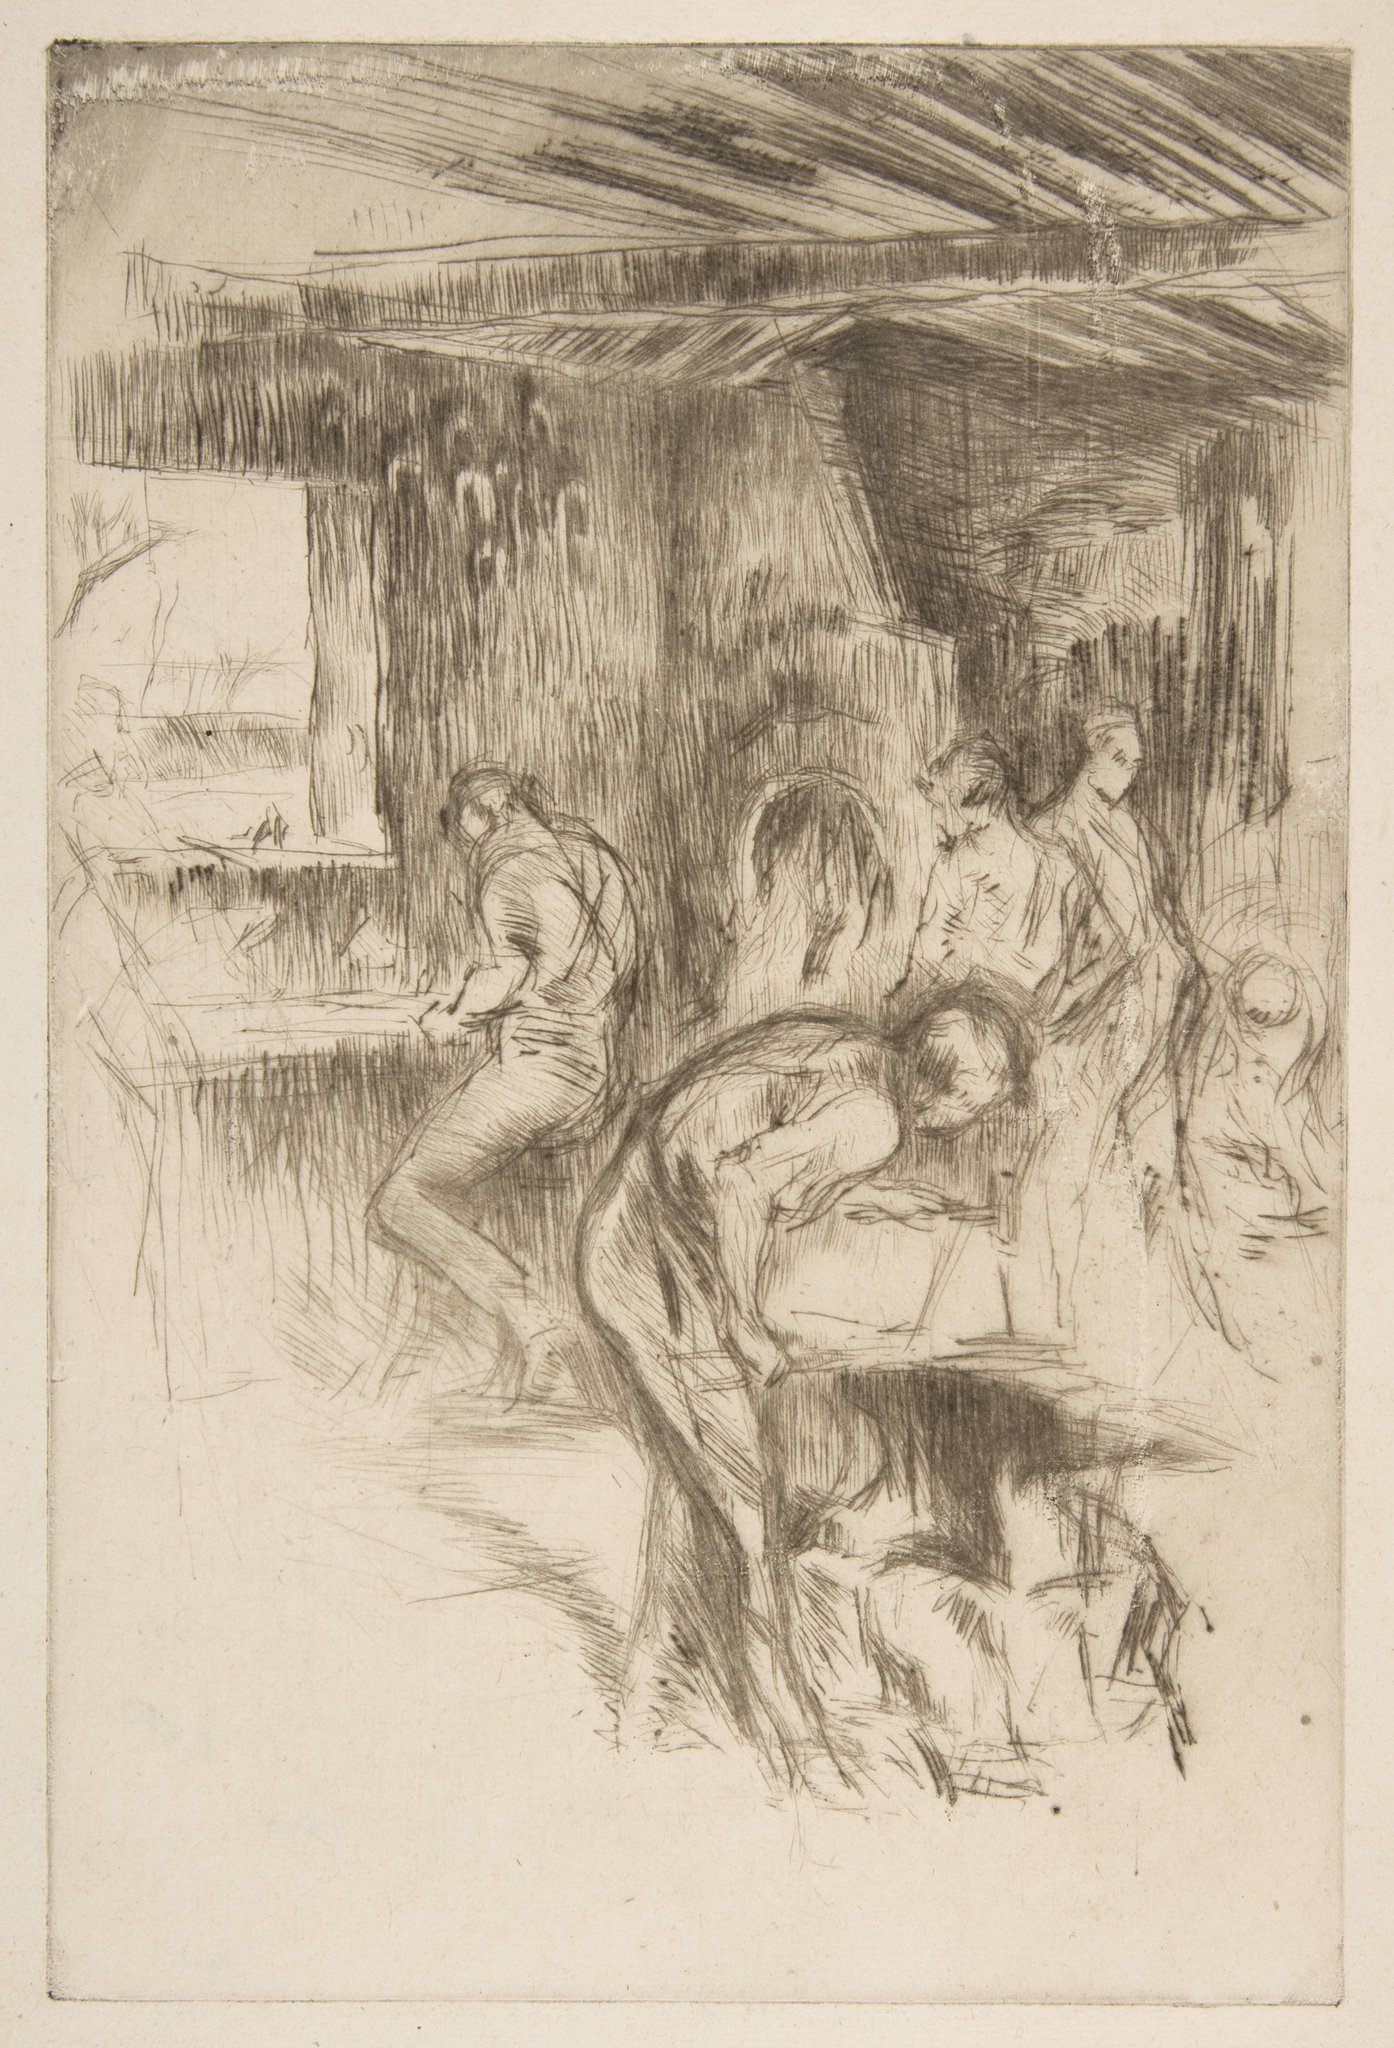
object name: print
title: The Little Forge (The Little Forge, Liverpool)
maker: james mcneill whistler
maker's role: artist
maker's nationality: american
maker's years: 1834-1903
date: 1875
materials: ink, paper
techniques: drypoint, printing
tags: men,women